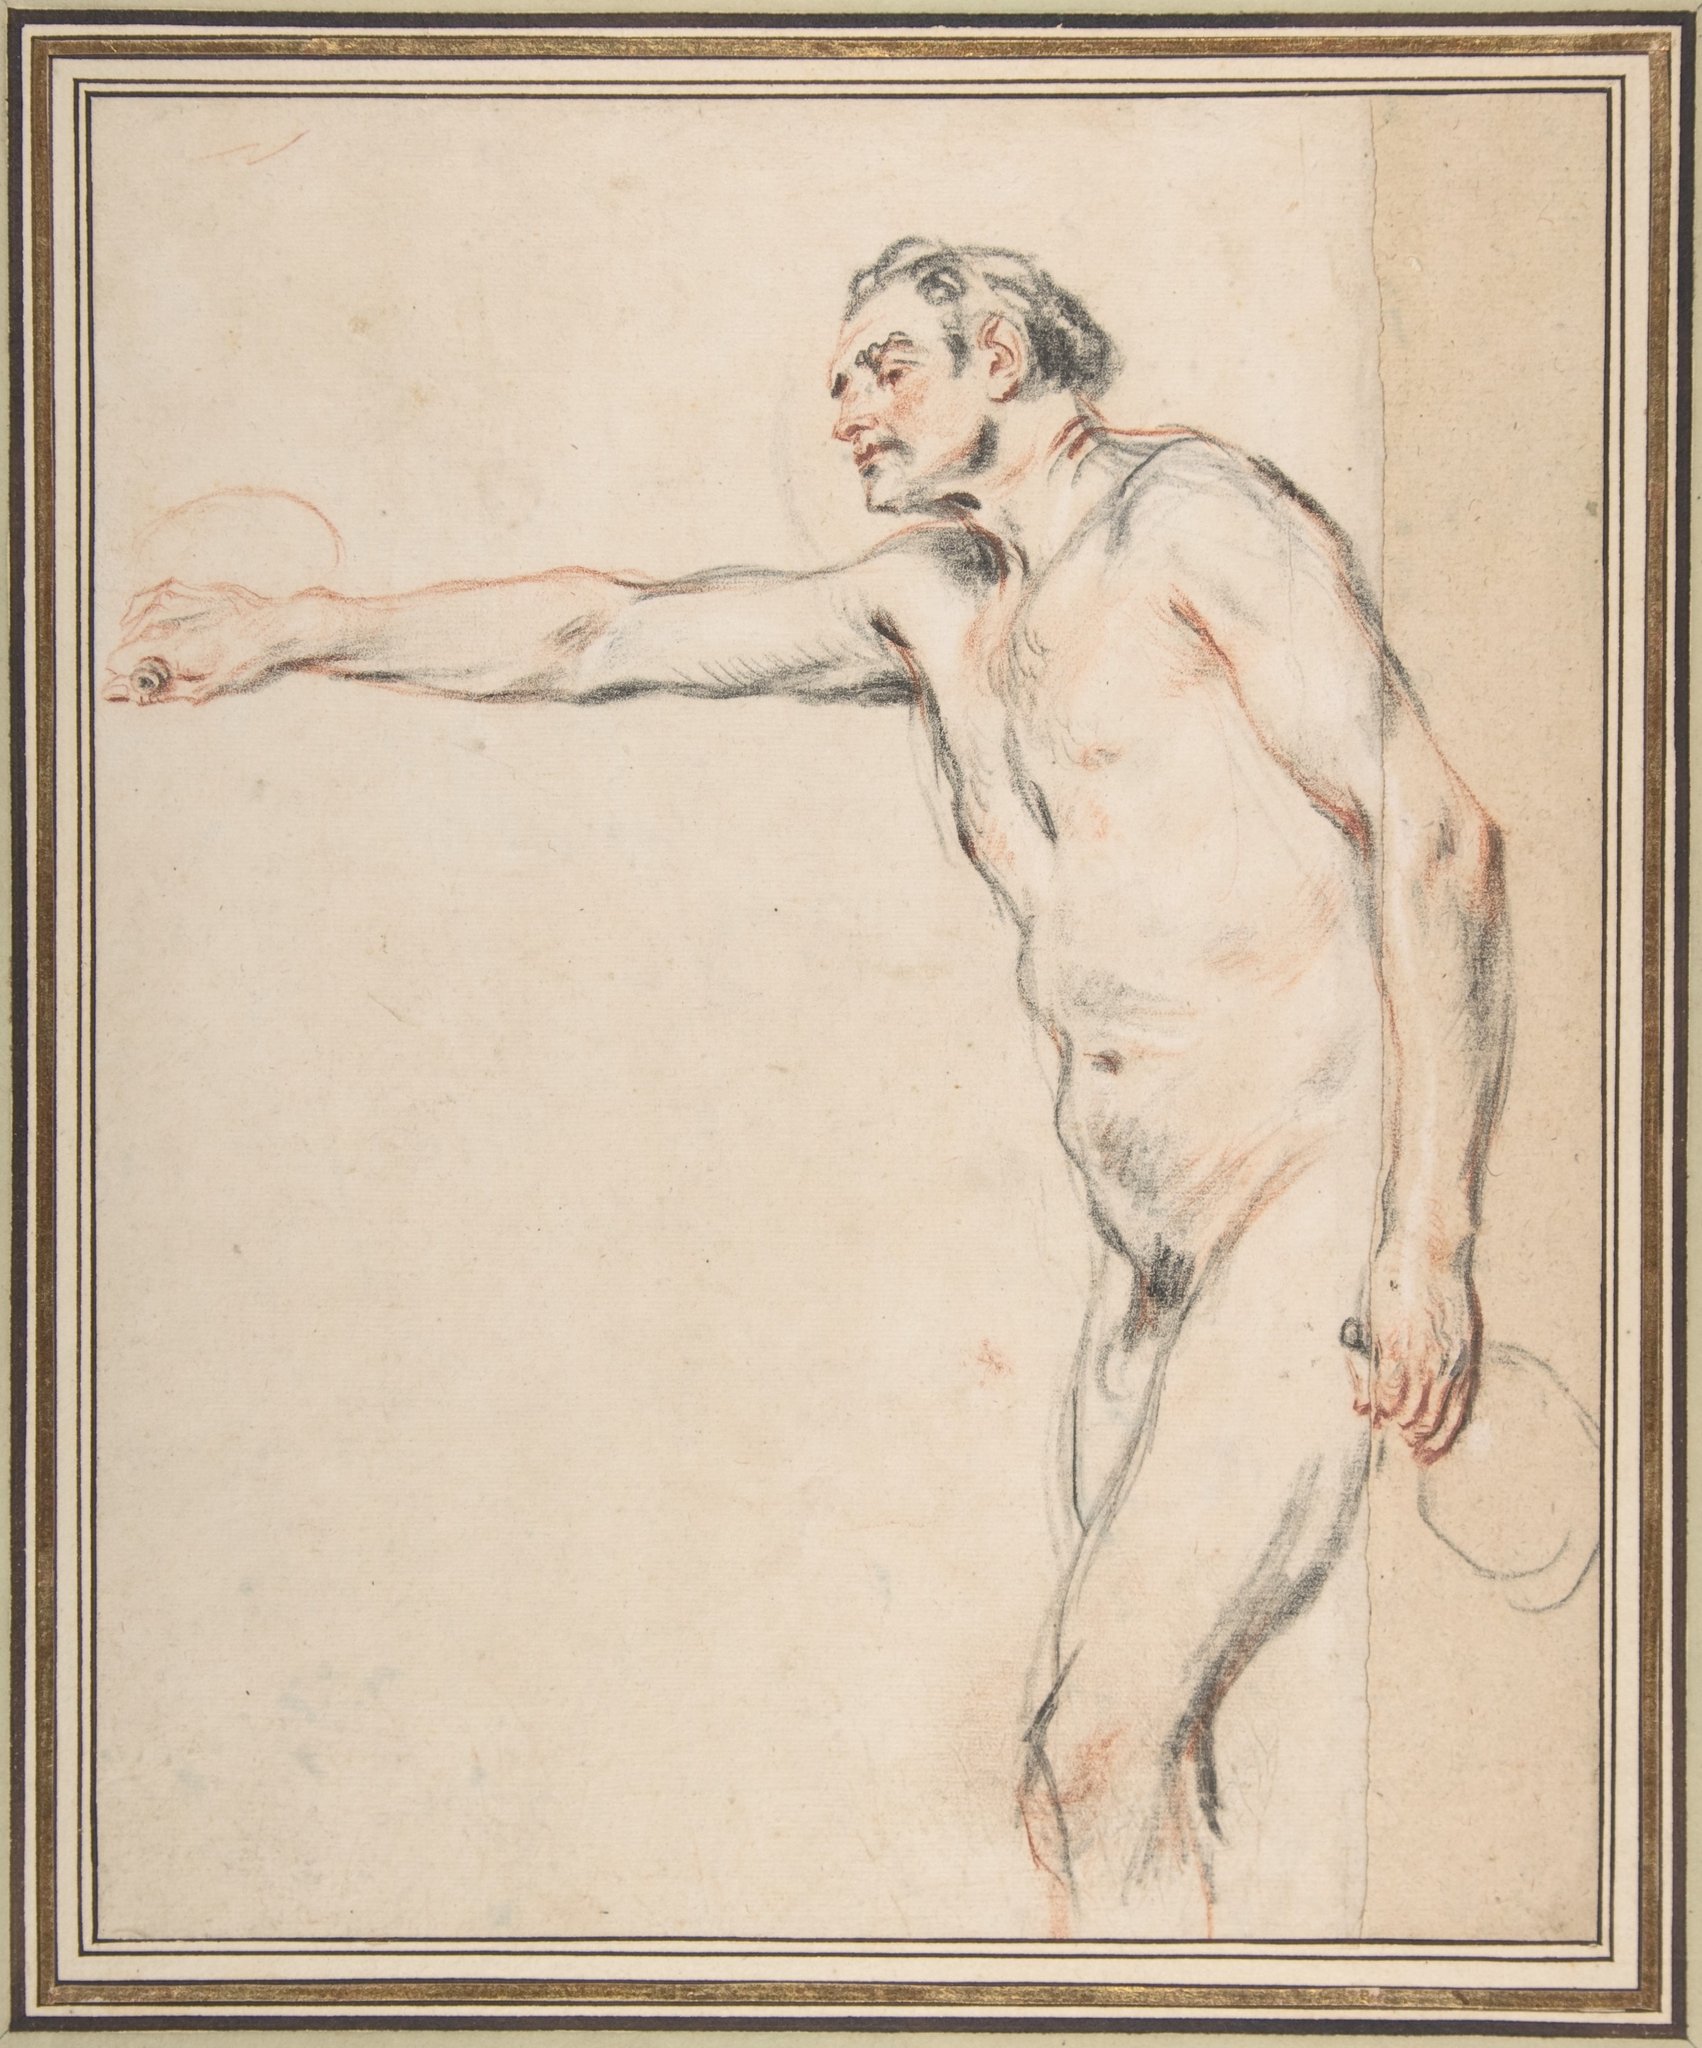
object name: drawing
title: Study of a Nude Man Holding Bottles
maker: antoine watteau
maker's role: artist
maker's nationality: french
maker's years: 1684-1721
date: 1715-1716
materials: chalk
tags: male nudes,bottles